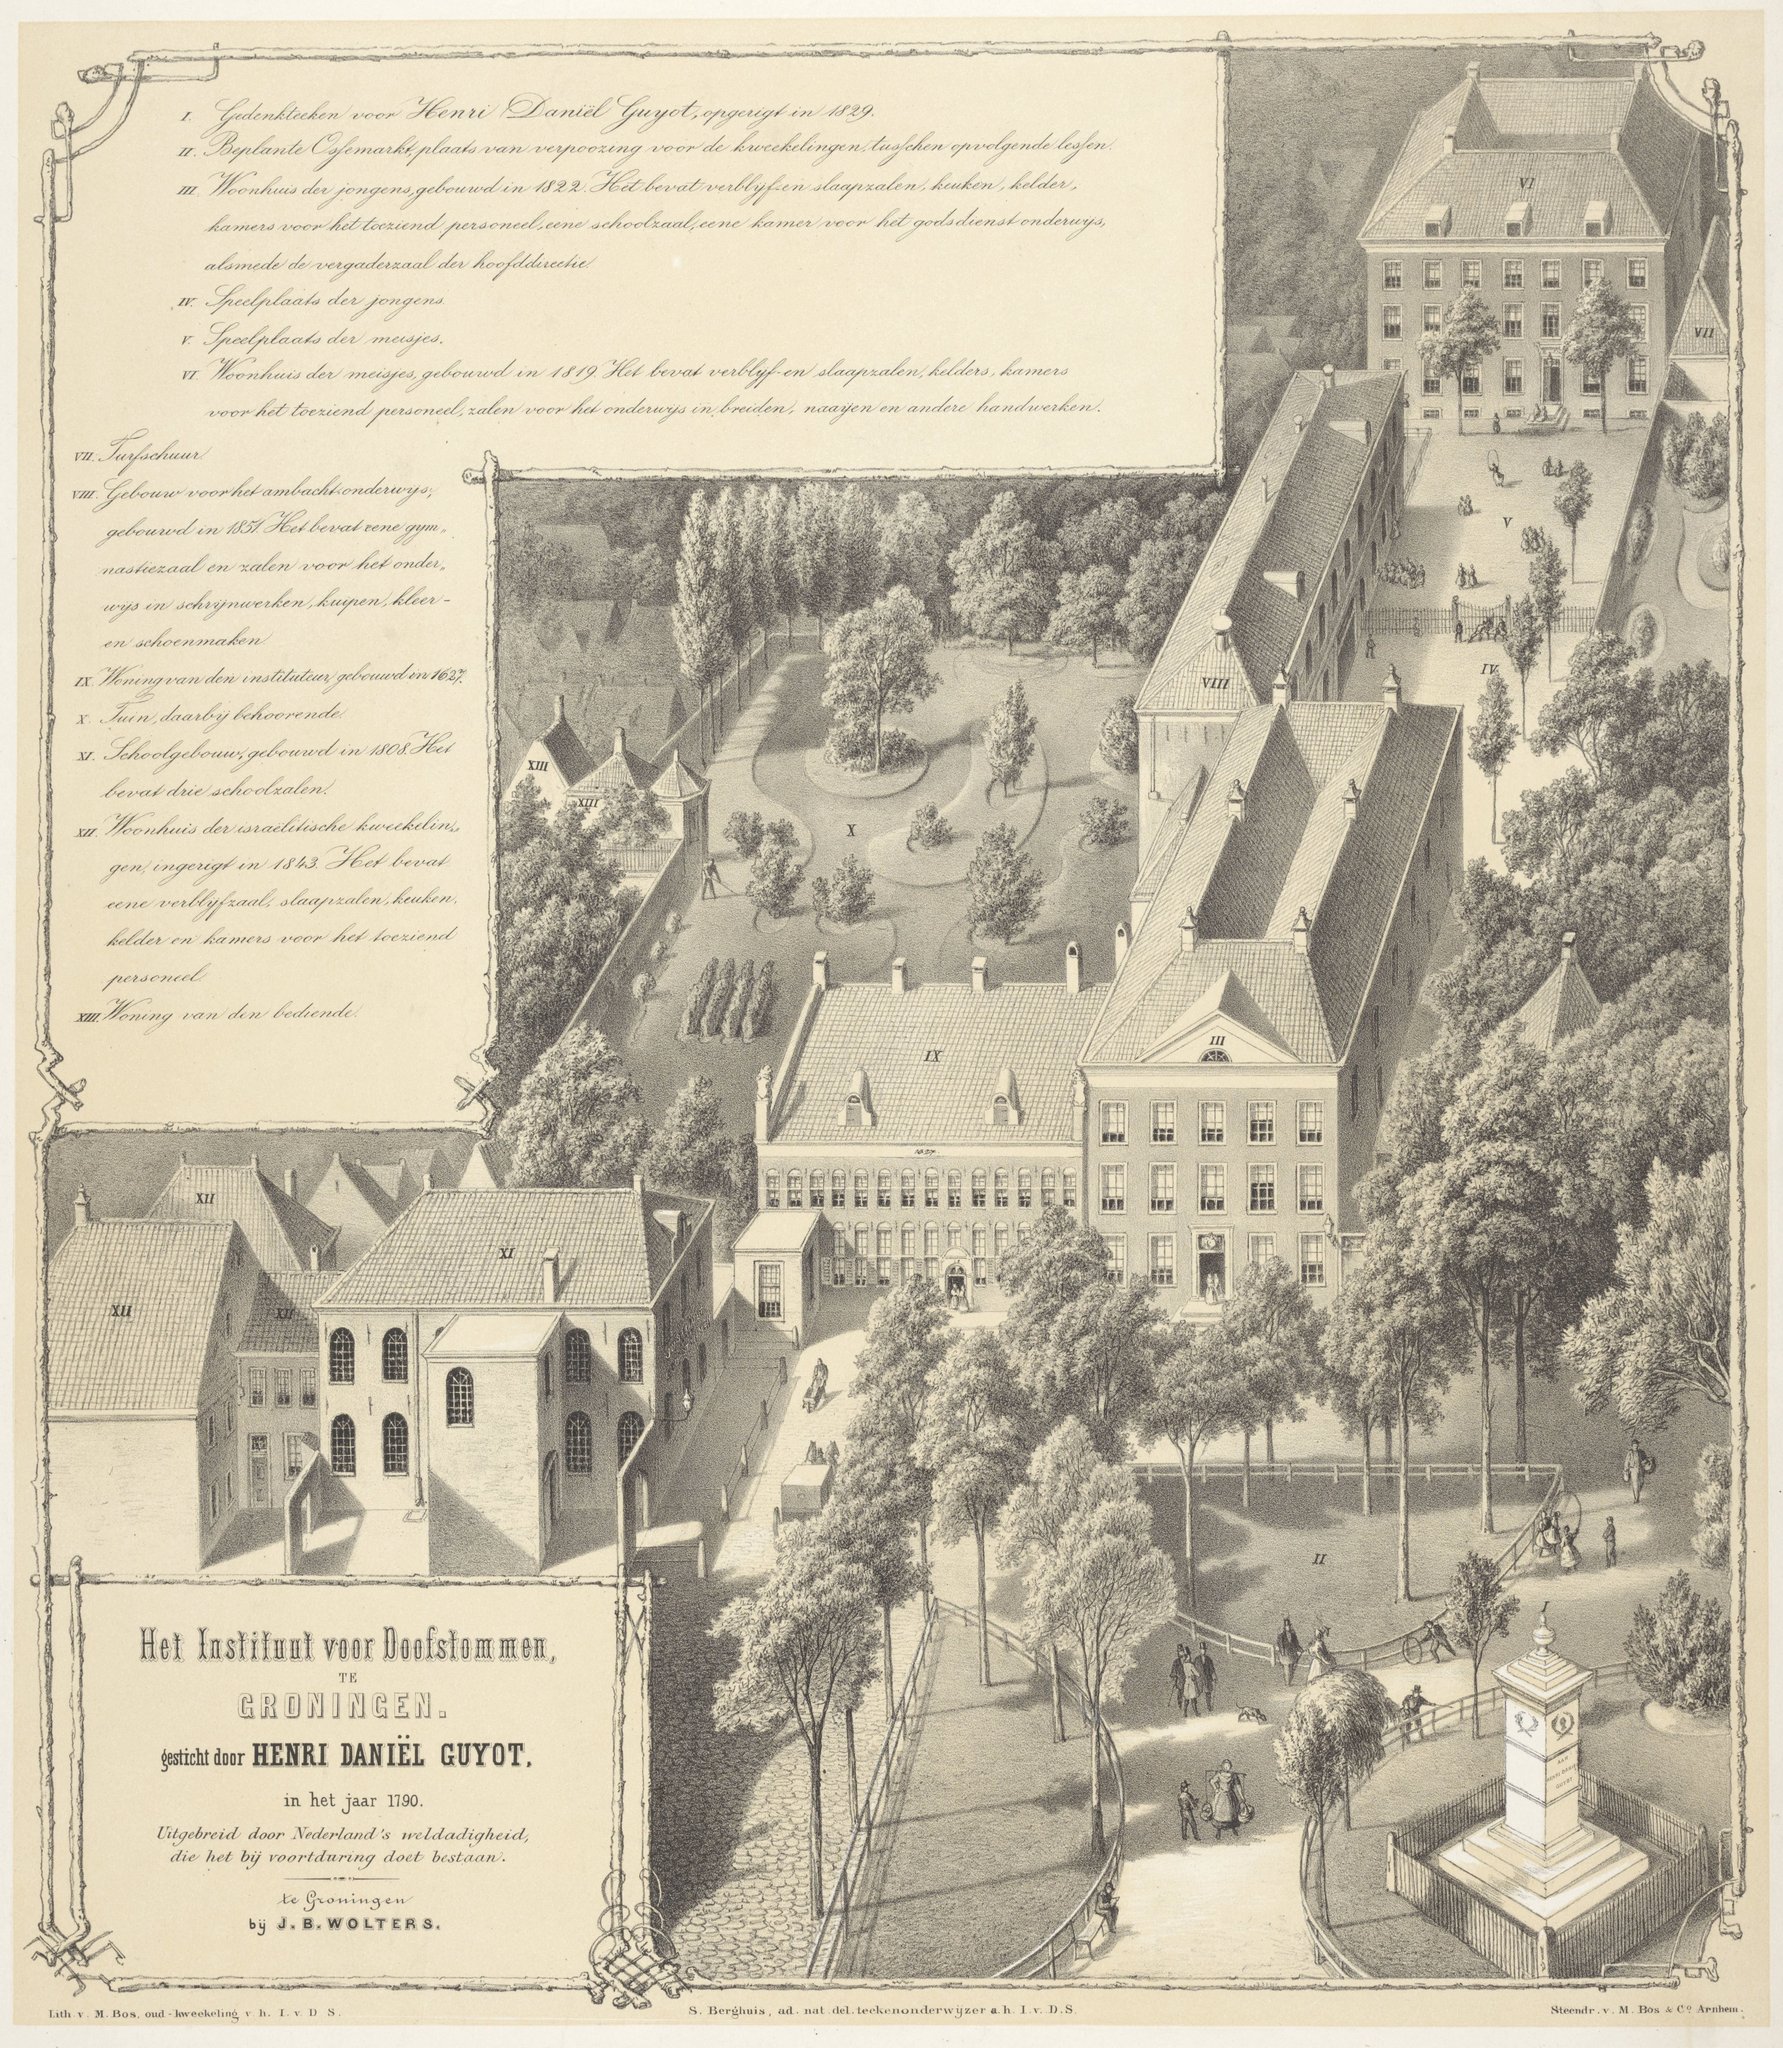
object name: print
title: Instituut voor doofstommen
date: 1862-1867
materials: paper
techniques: tone lithography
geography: groningen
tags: city-view, and landscape with man-made constructions, deaf, deafness, specialized institutions, landscape with monument, bird's eye view ~ representation of building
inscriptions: collector's mark: Lugt 2228, collector's mark: Lugt 2760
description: Het instituut is vanuit de lucht gezien. In de linkerbovenhoek een legenda met Romeinse cijfers die corresponderen met cijfers bij de gebouwen. Rechtsonder een gedenkteken voor Henri Daniël Guyot, de oprichter van het instituut.